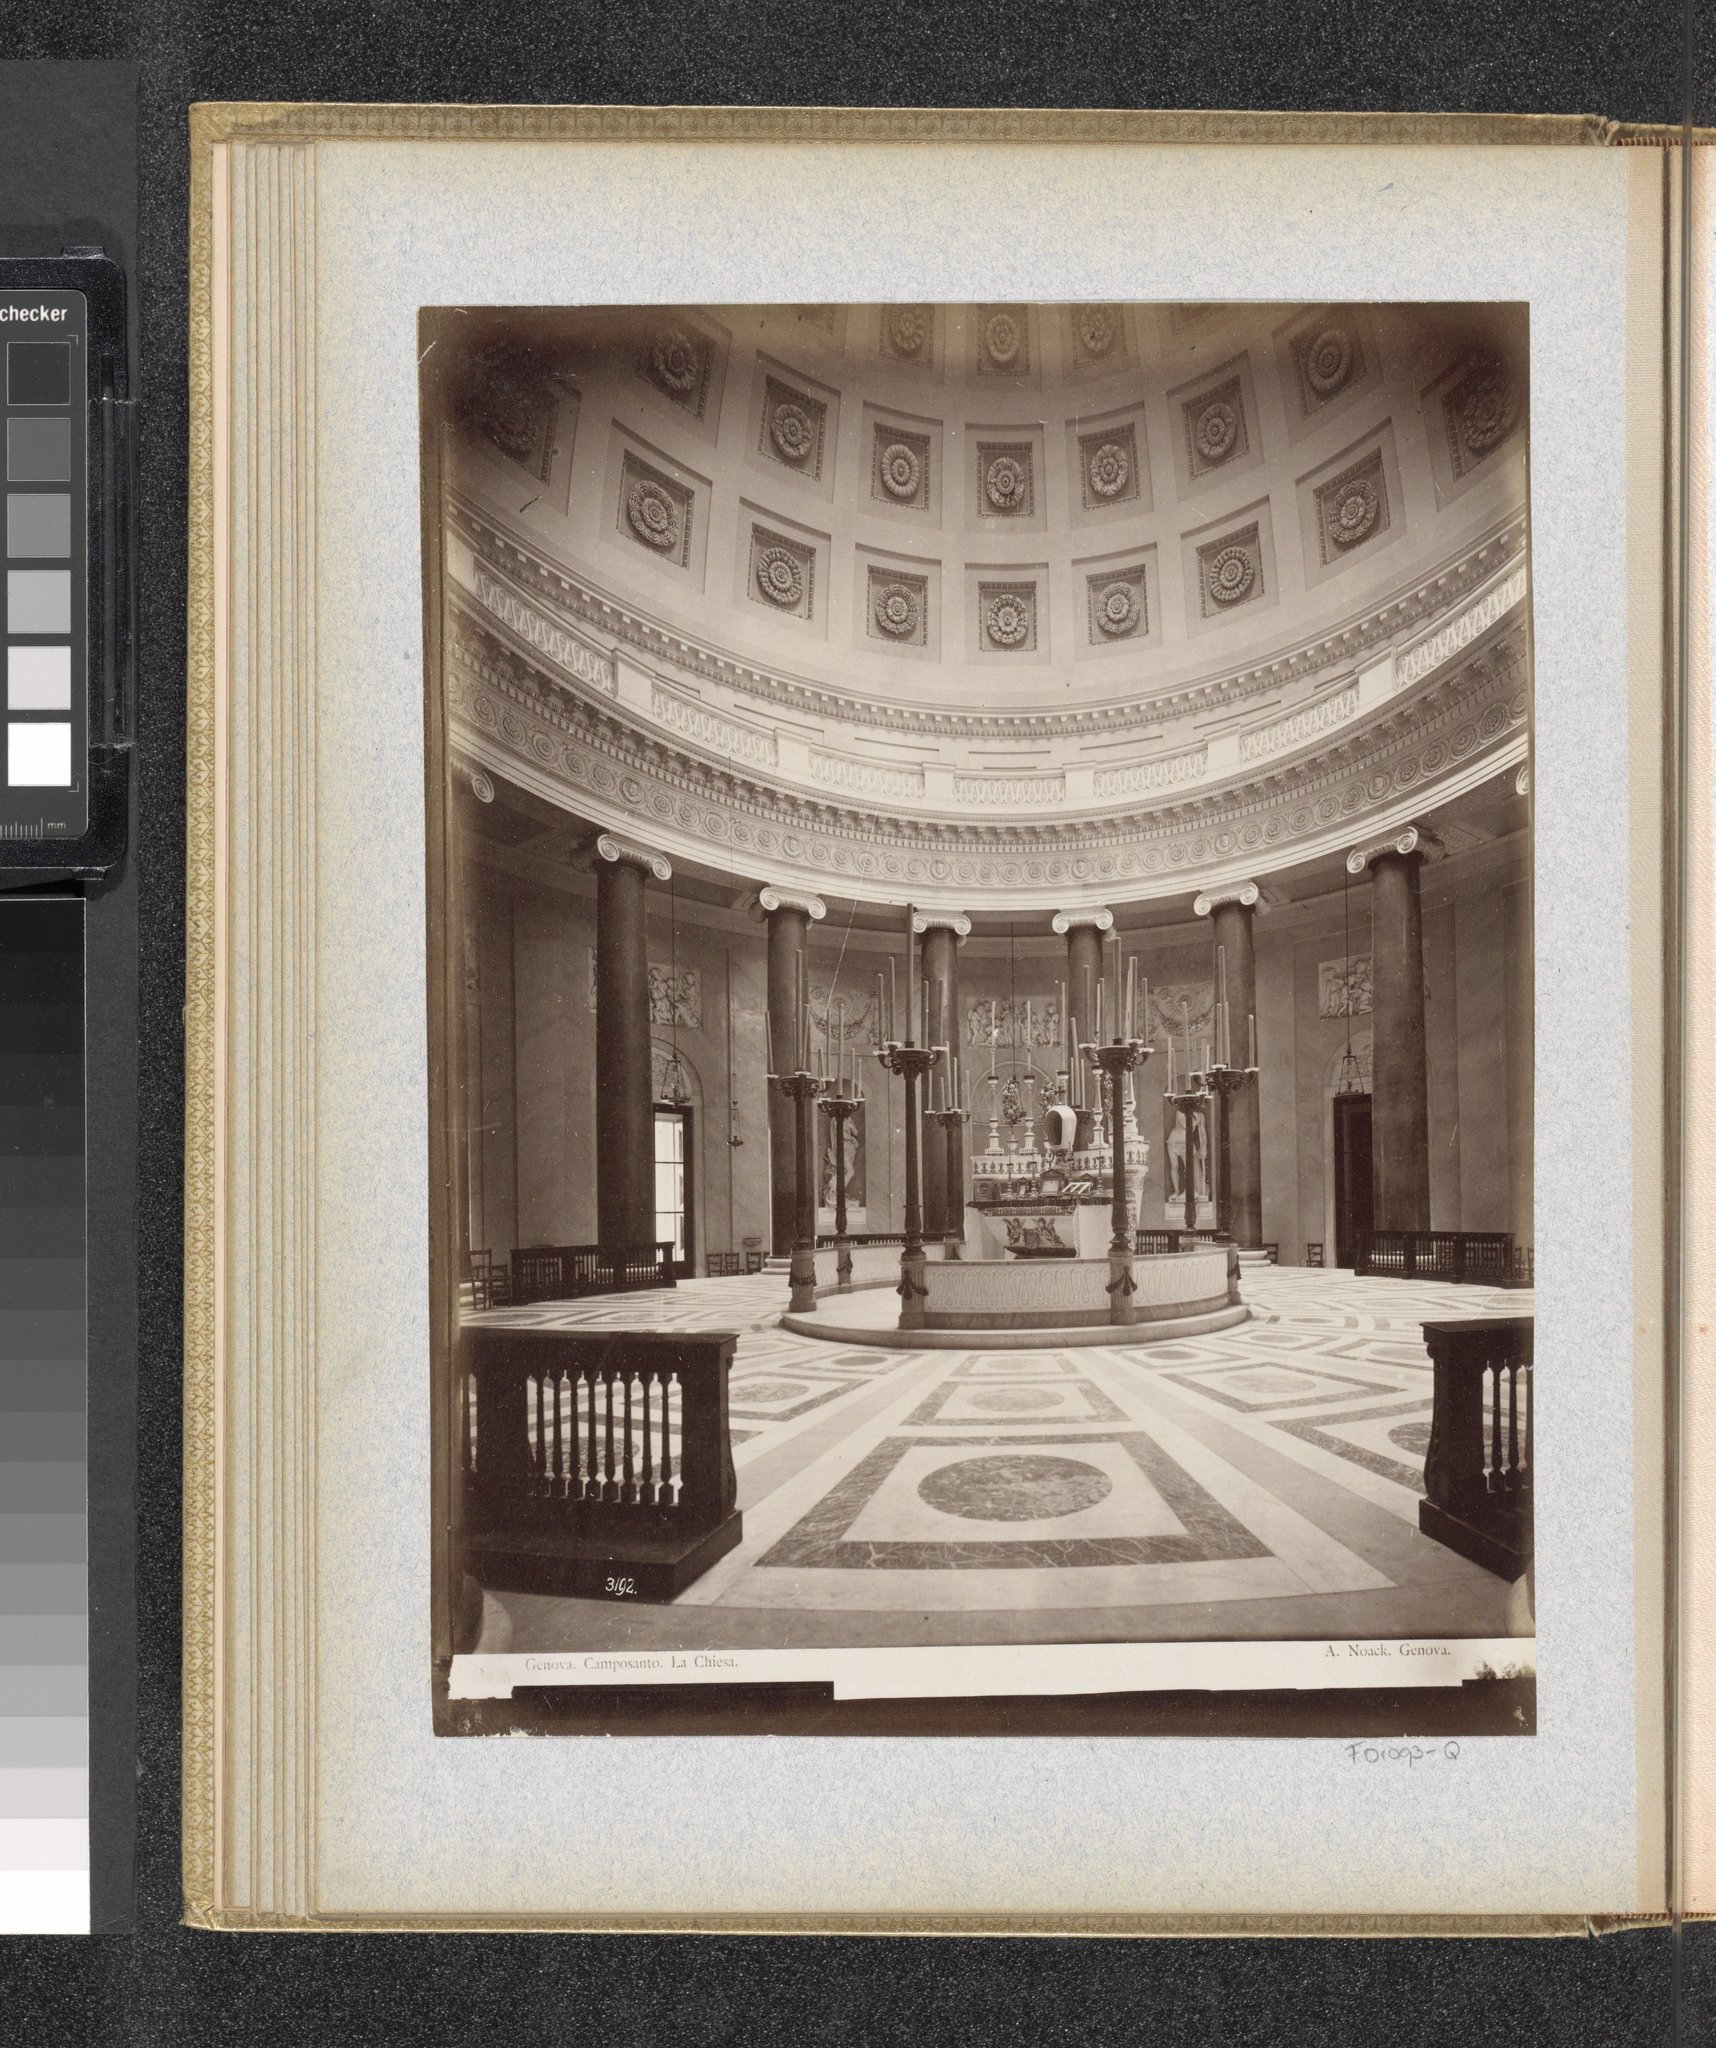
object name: photograph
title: Genova. Camposanto. La Chiesa.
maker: alfredo noack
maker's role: fotograaf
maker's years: 1833-1895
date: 1870-1890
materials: paper, photographic support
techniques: albumen print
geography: genoa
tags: parts of church interior: dome, interior of church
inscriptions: negative number: ‘3192’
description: Onderdeel van Reisalbum met foto's van bezienswaardigheden in Genua, Florence en Venetië.